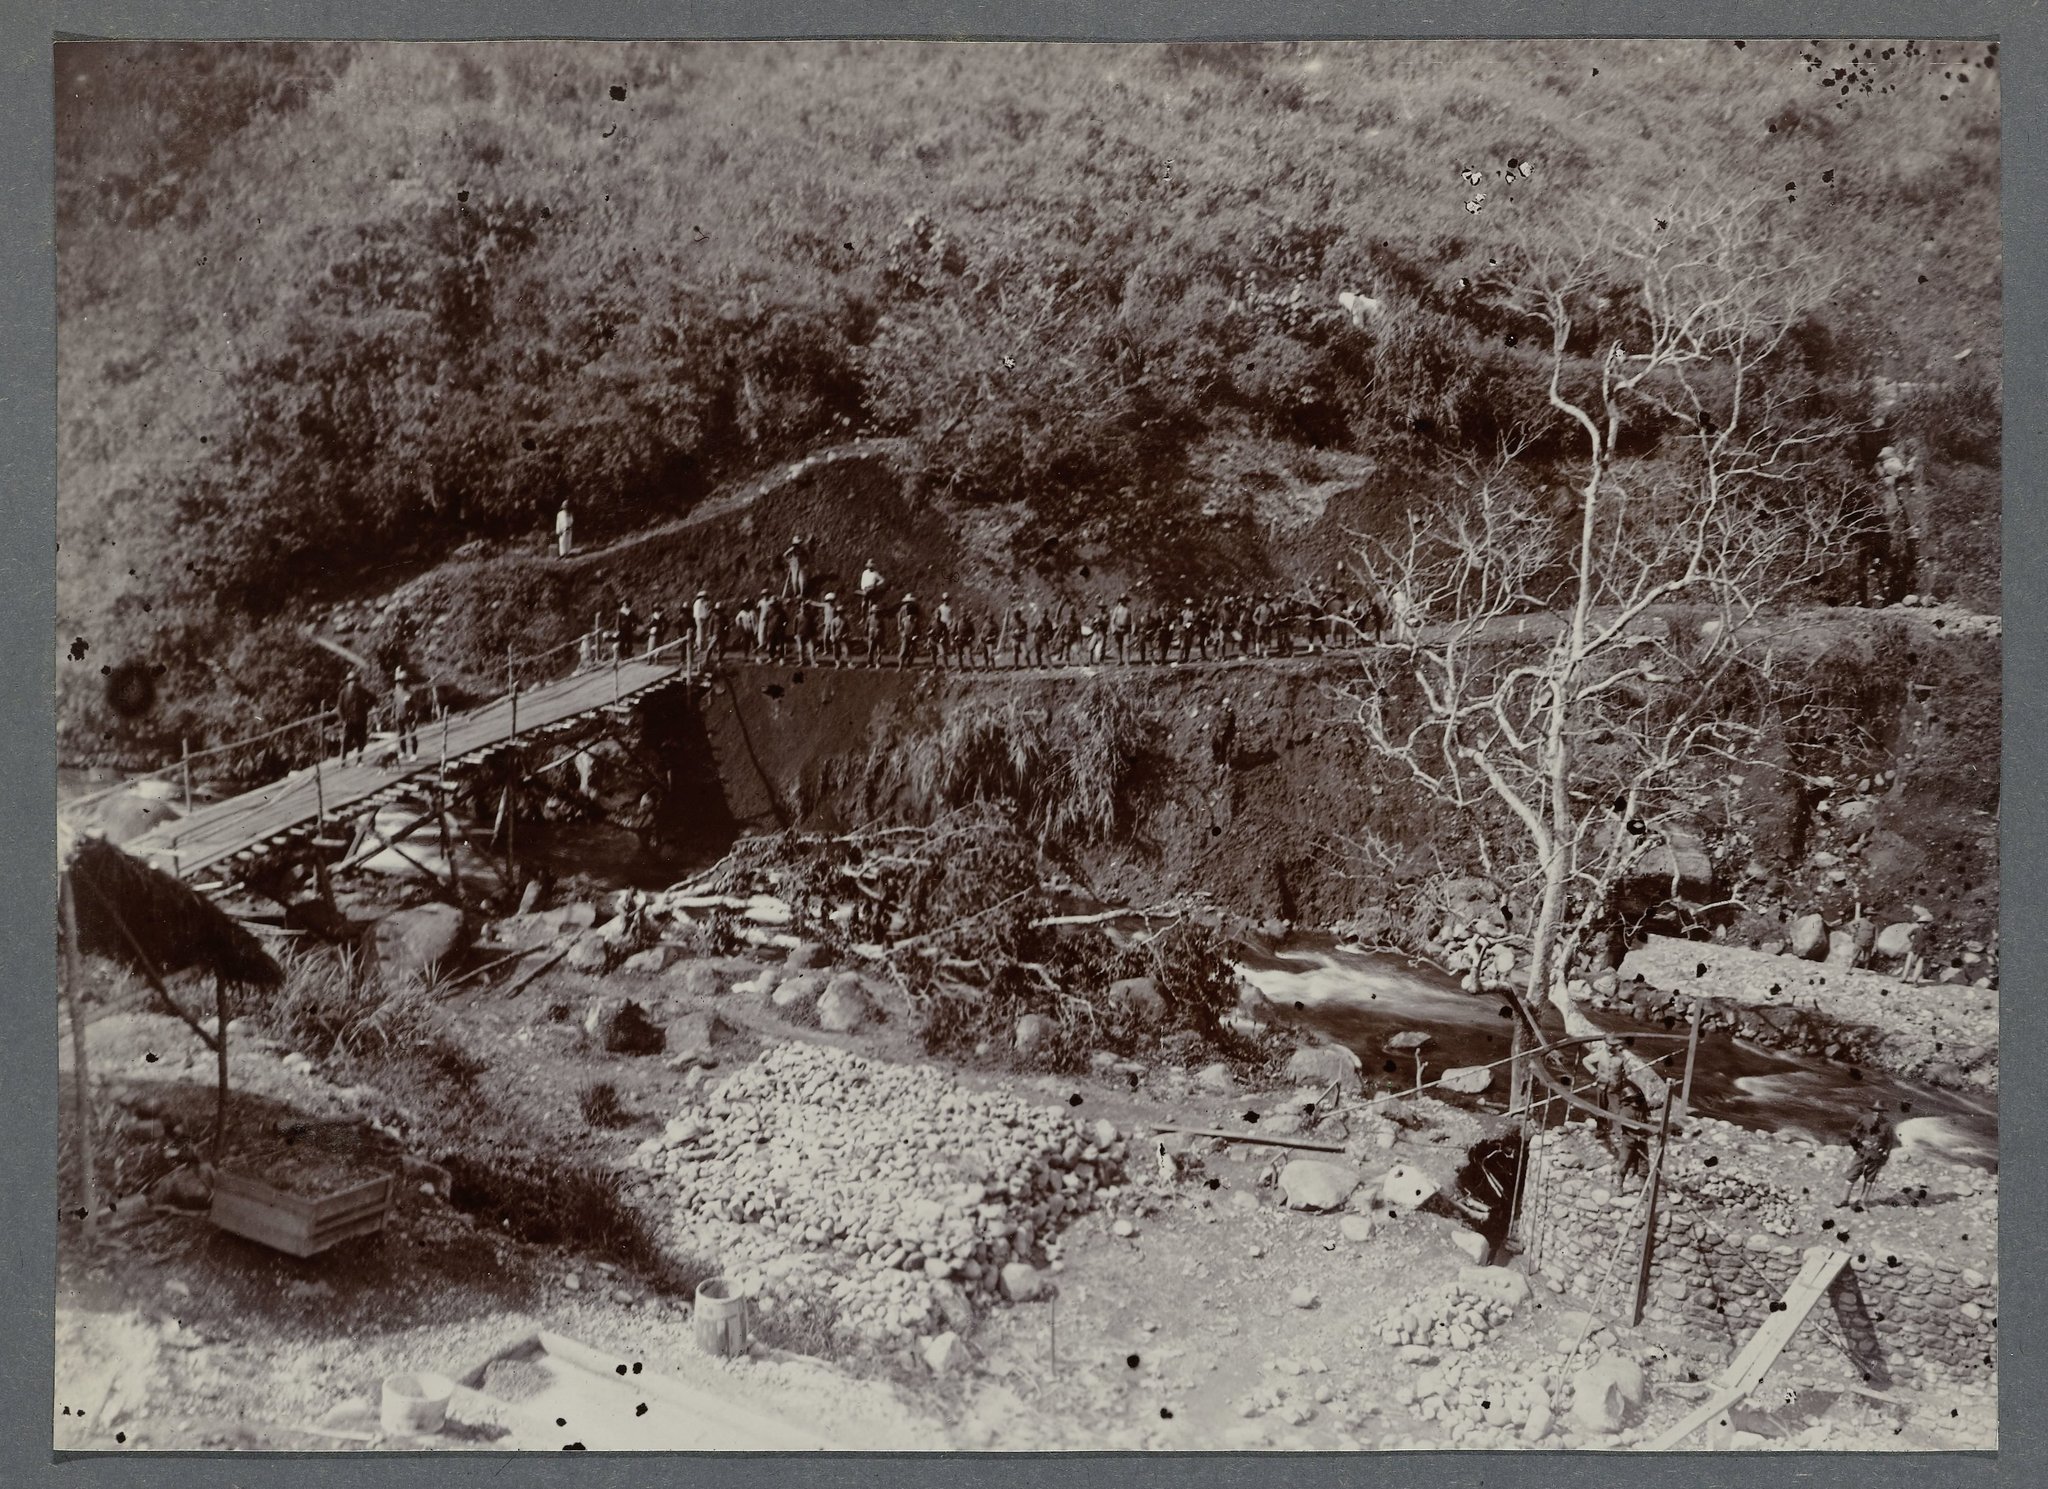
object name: photograph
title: Begin van de bouw van de brug over de Woih ni Enang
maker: Anonymous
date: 1903-1913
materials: photographic support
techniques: gelatin silver print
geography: north sumatra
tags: arnhem, the hague, albertus dominicus laman trip, building activities, traffic by road or path with motor-vehicle, landscapes in tropical and sub-tropical regions, road, path, bridge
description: Na de expedities naar de Gajo- en Alaslanden o.l.v. Van Daalen (eerste tocht in 1901), werd hij in 1903 belast met voorbereiding van permanente vestiging van Nederlands gezag. Aanleg van een weg van de Noordkust naar het binnenland was hierbij van groot belang. Deze zgn. Gajoweg werd aangelegd tussen 1903 en 1914, van Bireuen aan de kust naar Takinguen aan het bergmeer Danau Lauttawar, totale lengte 104 km.